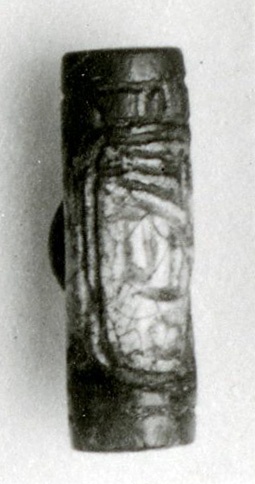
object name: cylinder seal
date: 1640-1550 BCE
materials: stone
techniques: glazing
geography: egypt